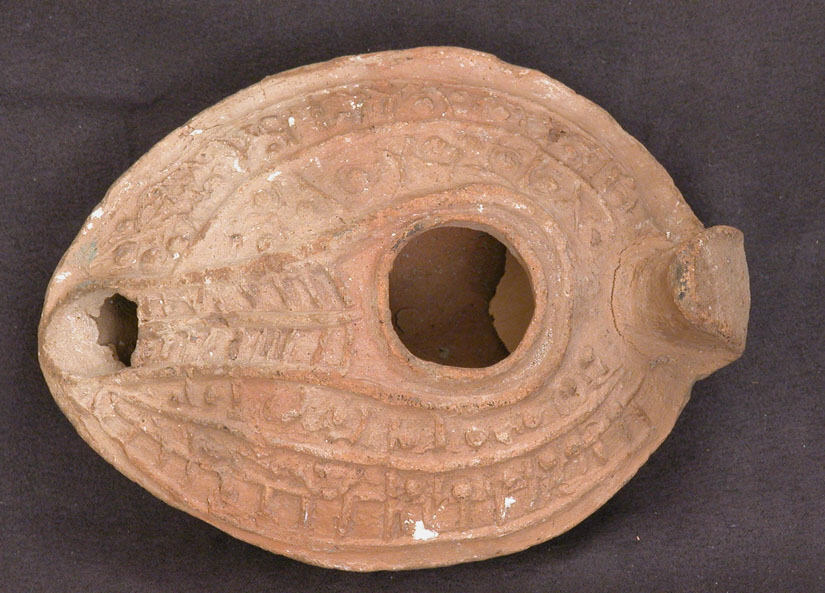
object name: lamp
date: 601-1100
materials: earthenware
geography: palestine